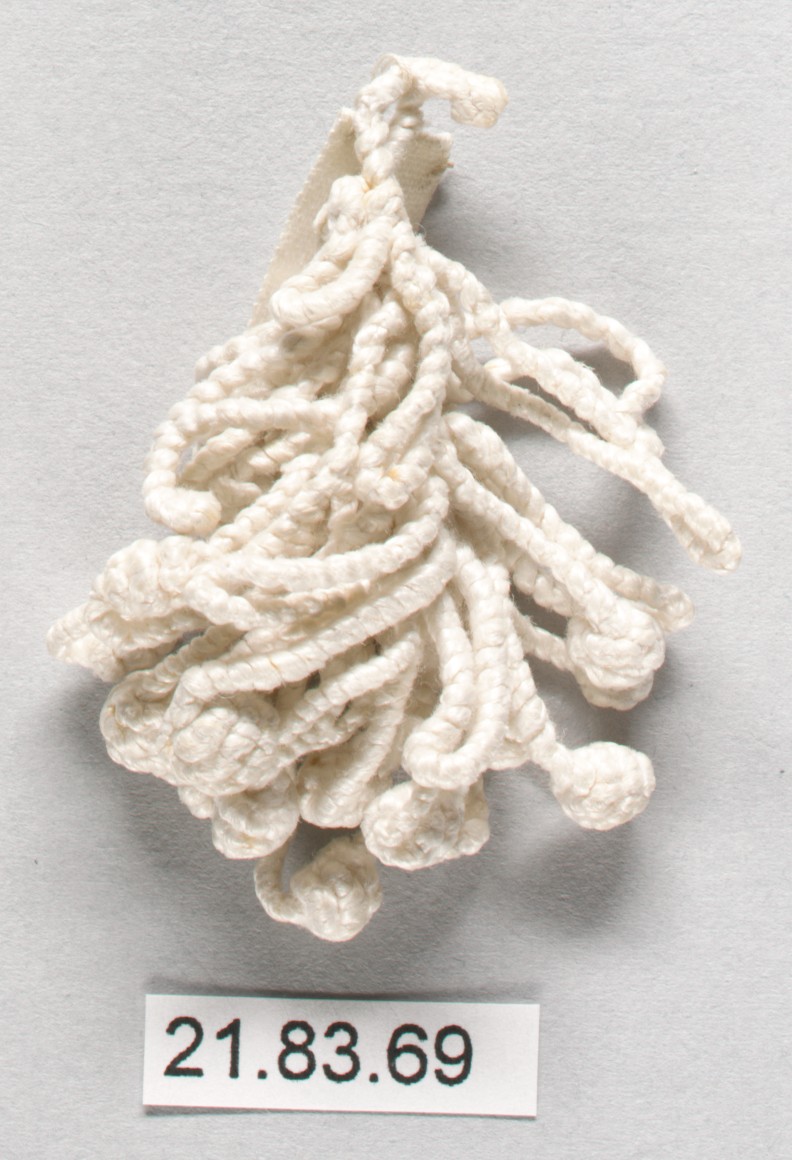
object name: tassel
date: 1601-1700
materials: linen